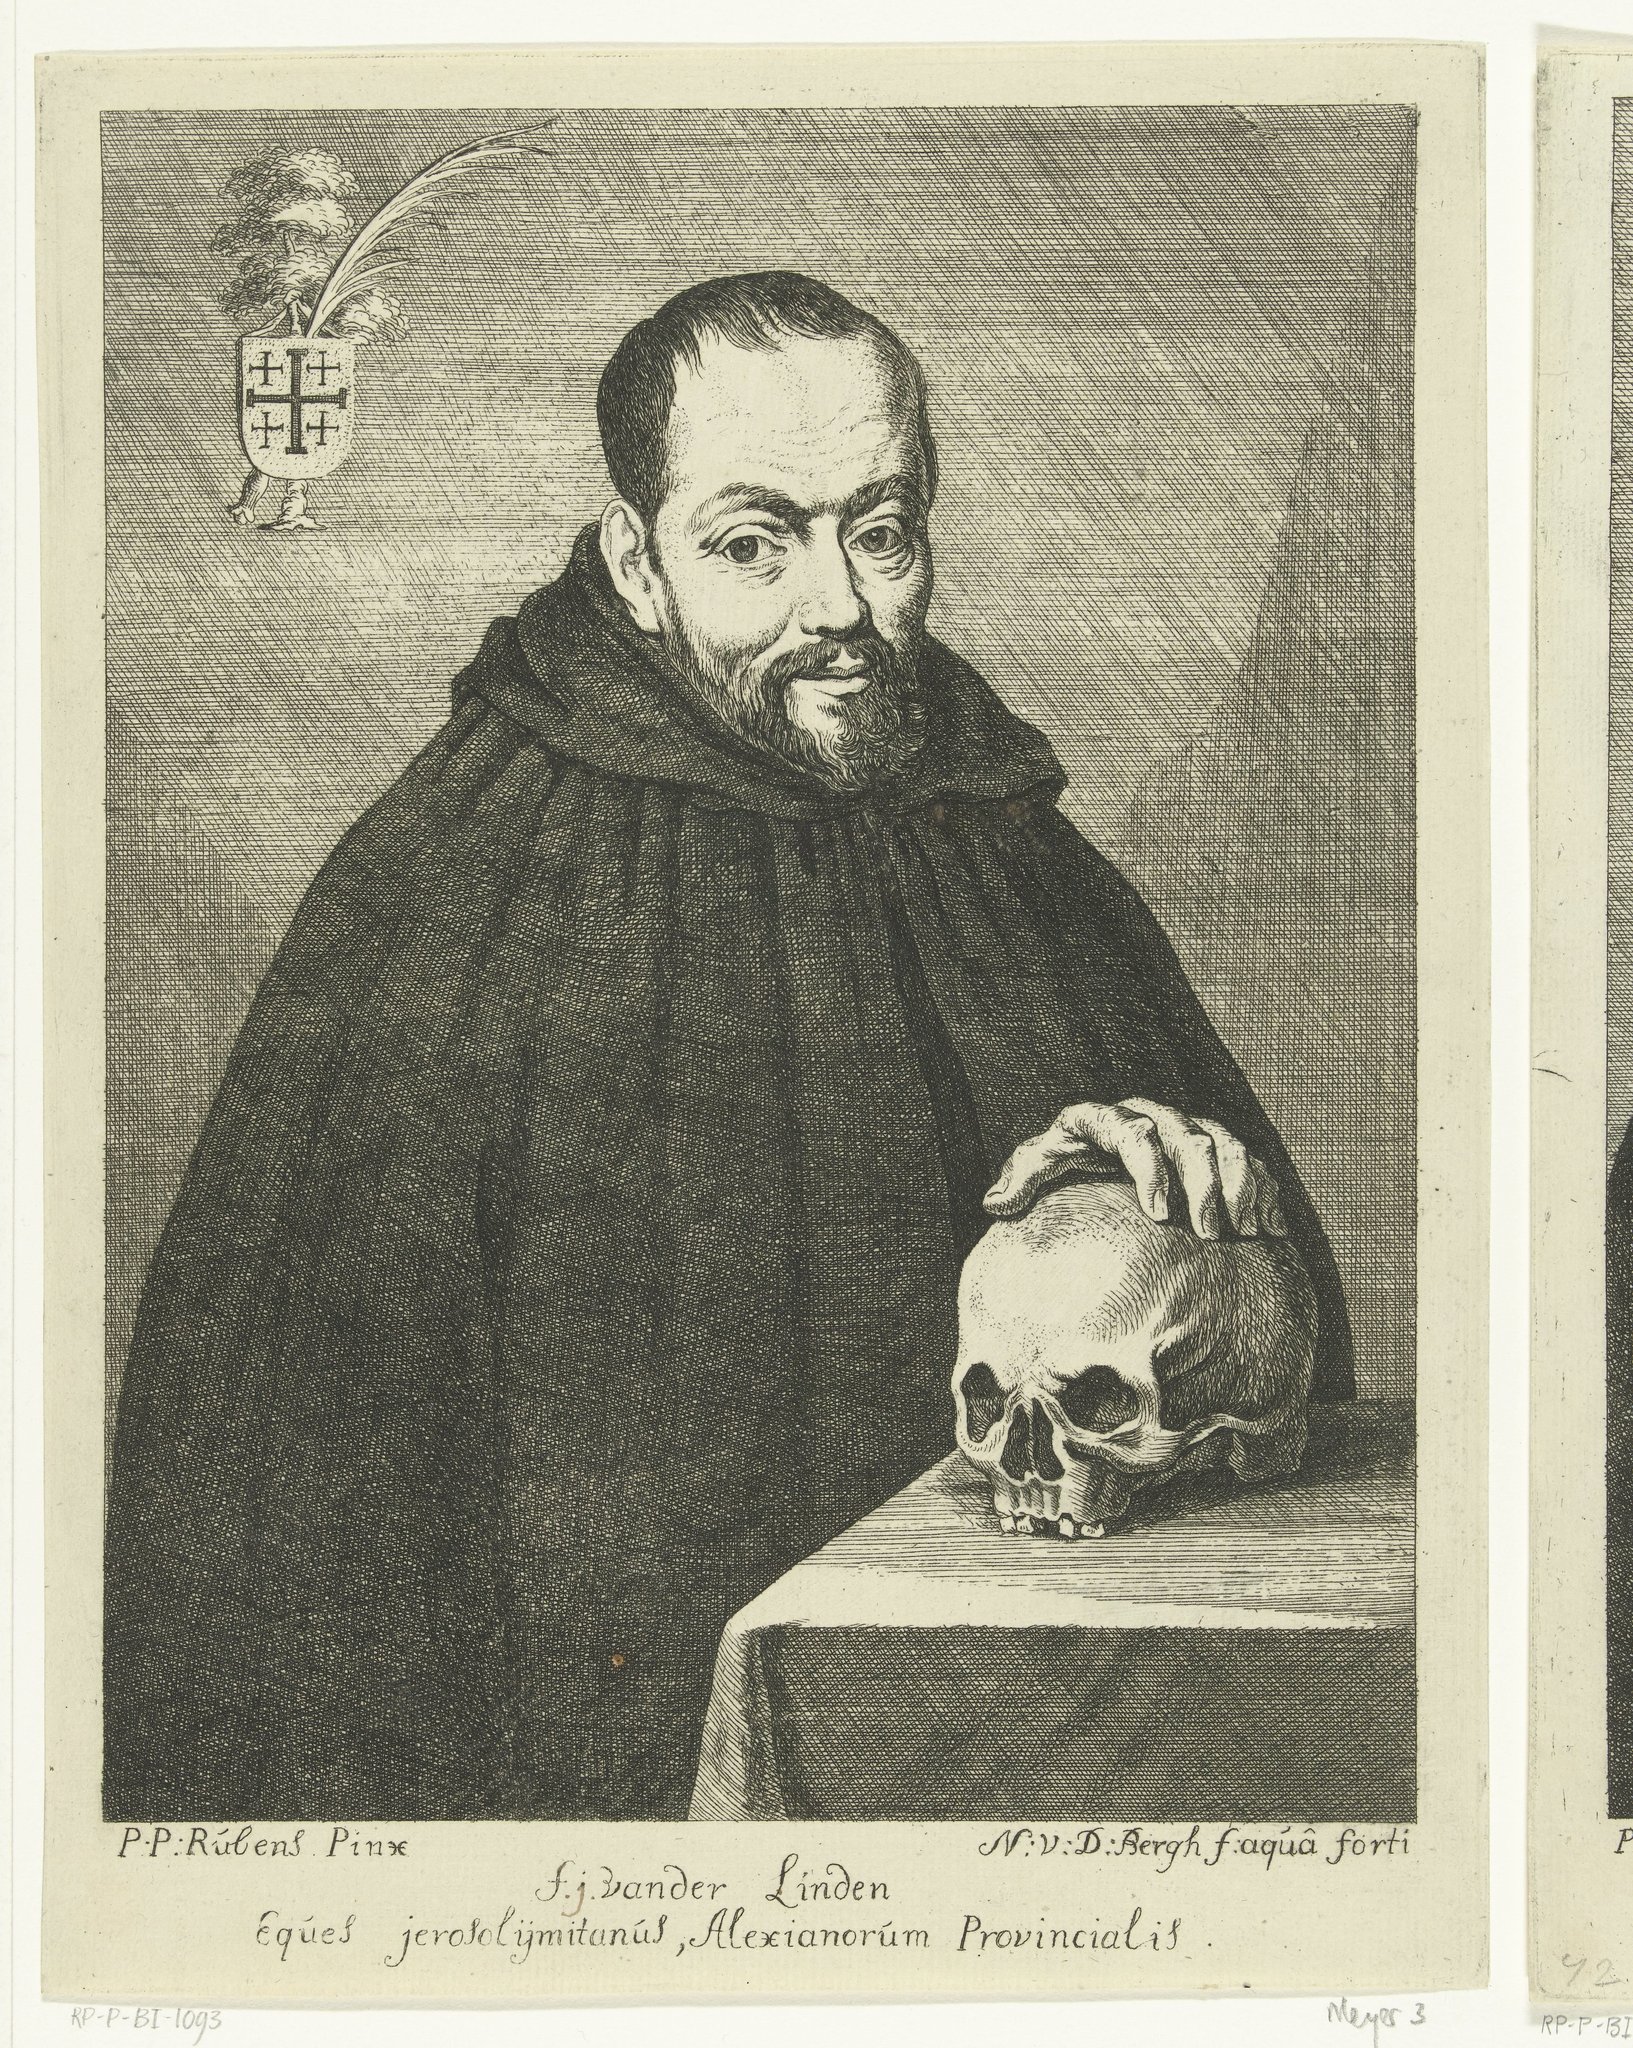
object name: print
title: F.J. van der Linden Eqúes jerosolymitanús, Alexianorúm Provincialis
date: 1735-1774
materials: paper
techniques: etching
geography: antwerp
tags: monk(s), friar(s), skull as symbol of 'vanitas'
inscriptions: collector's mark: Lugt 240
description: Prent naar schilderij van Peter Paul Rubens.